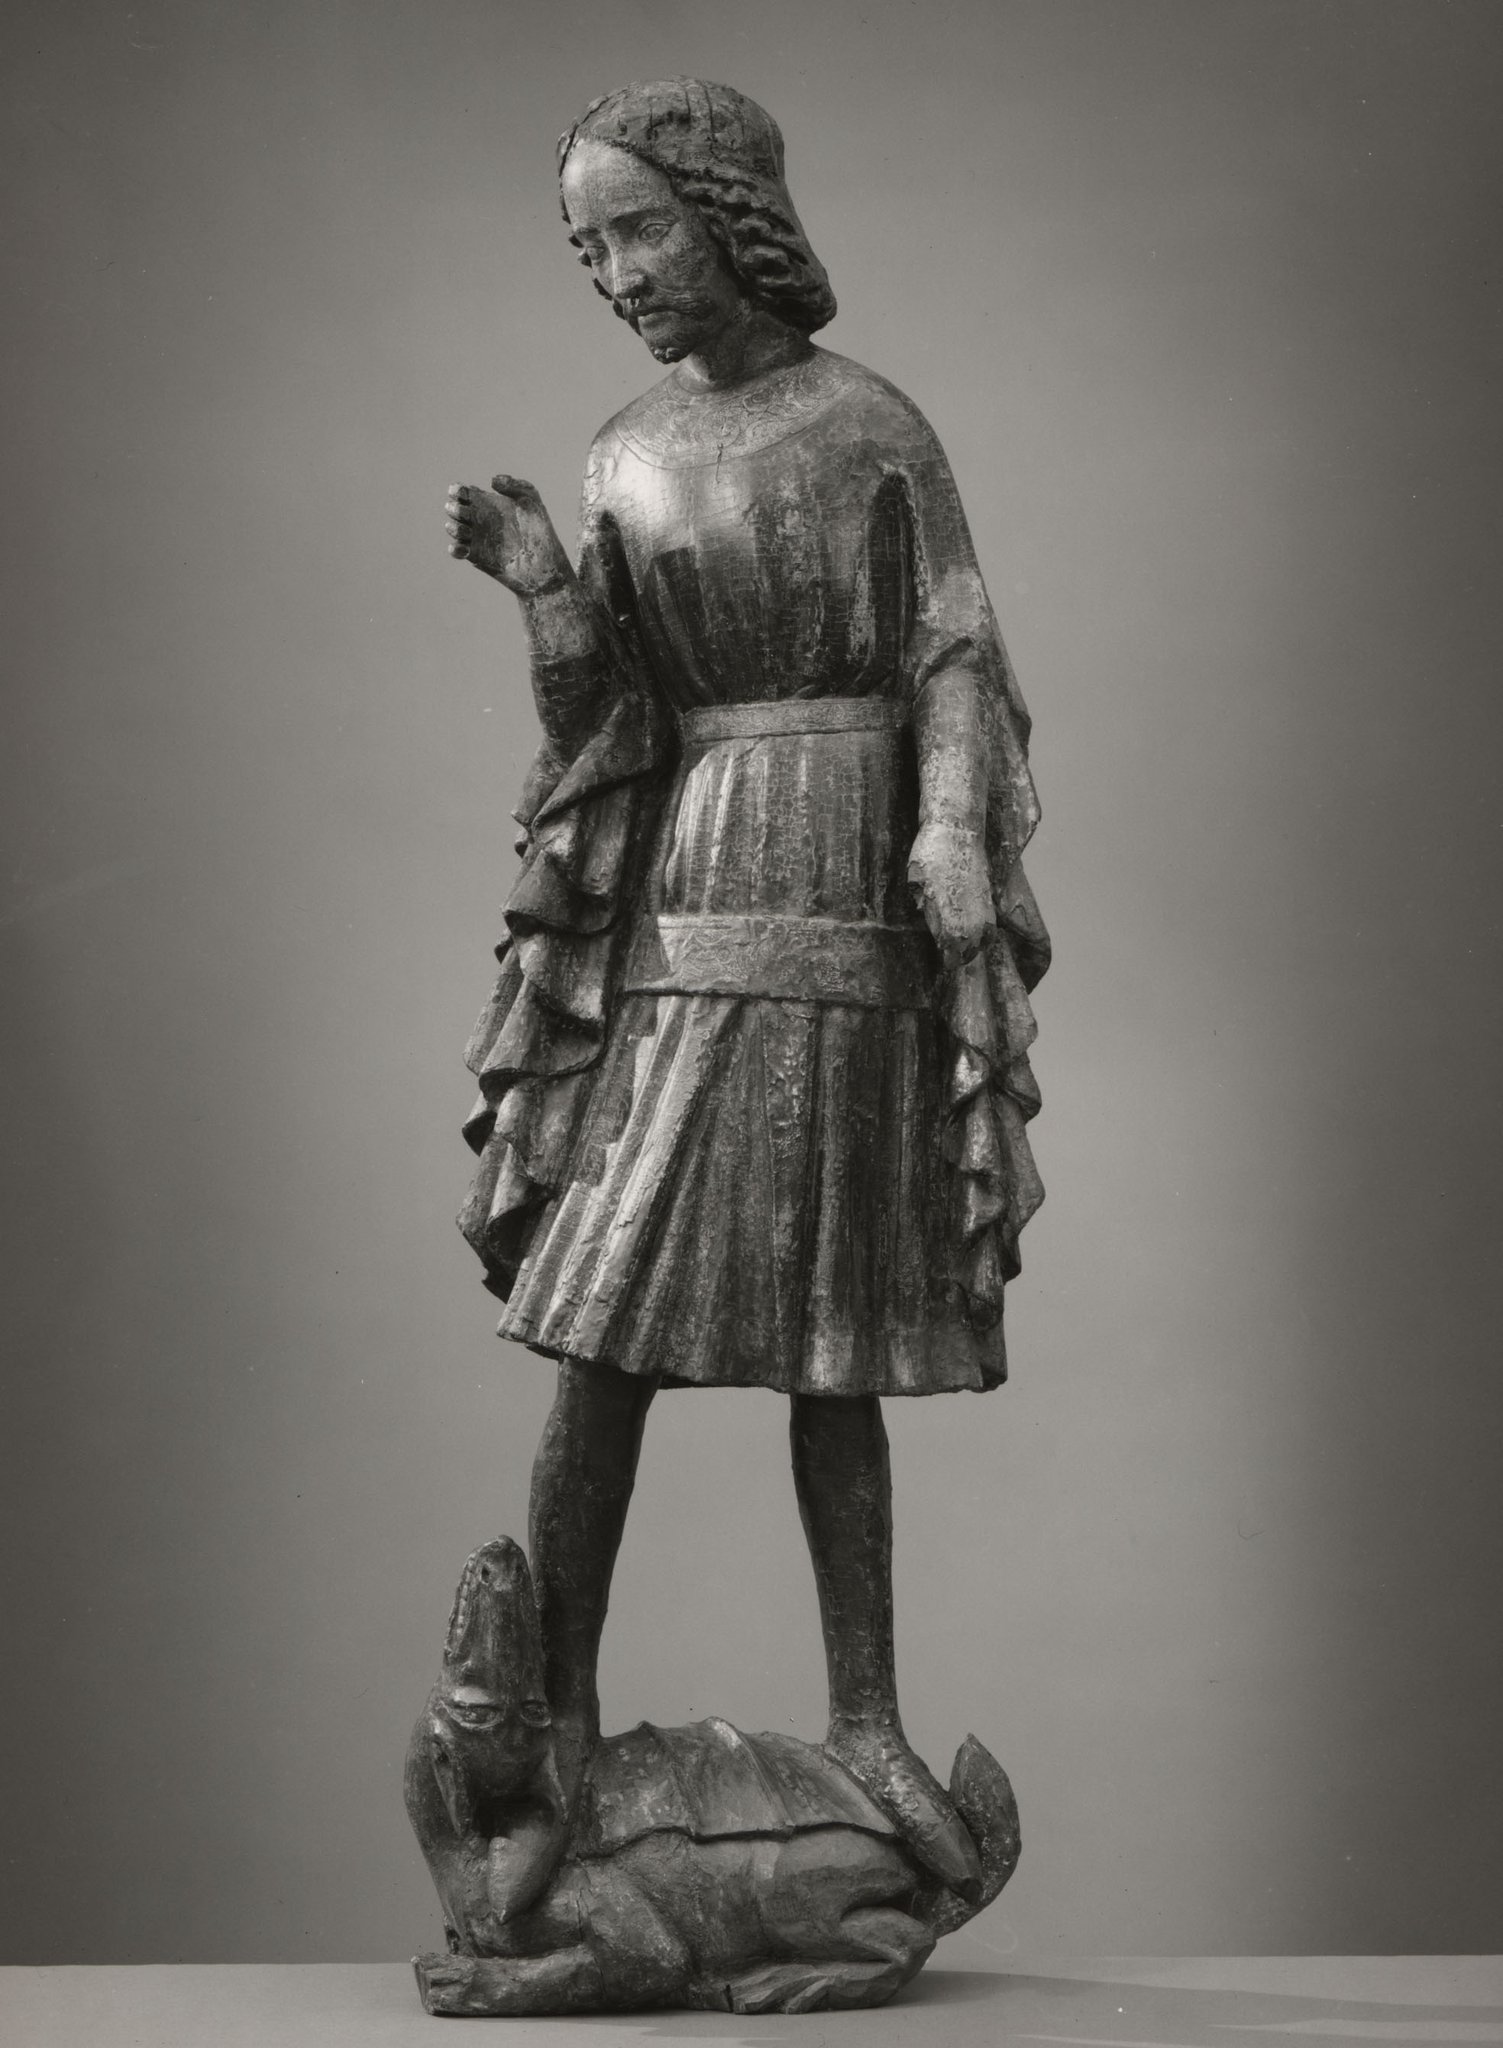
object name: statue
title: Saint George and the Dragon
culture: austrian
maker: hans von judenburg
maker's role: artist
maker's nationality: austrian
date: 1420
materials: wood, gilt, paint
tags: men,dragons,saint george